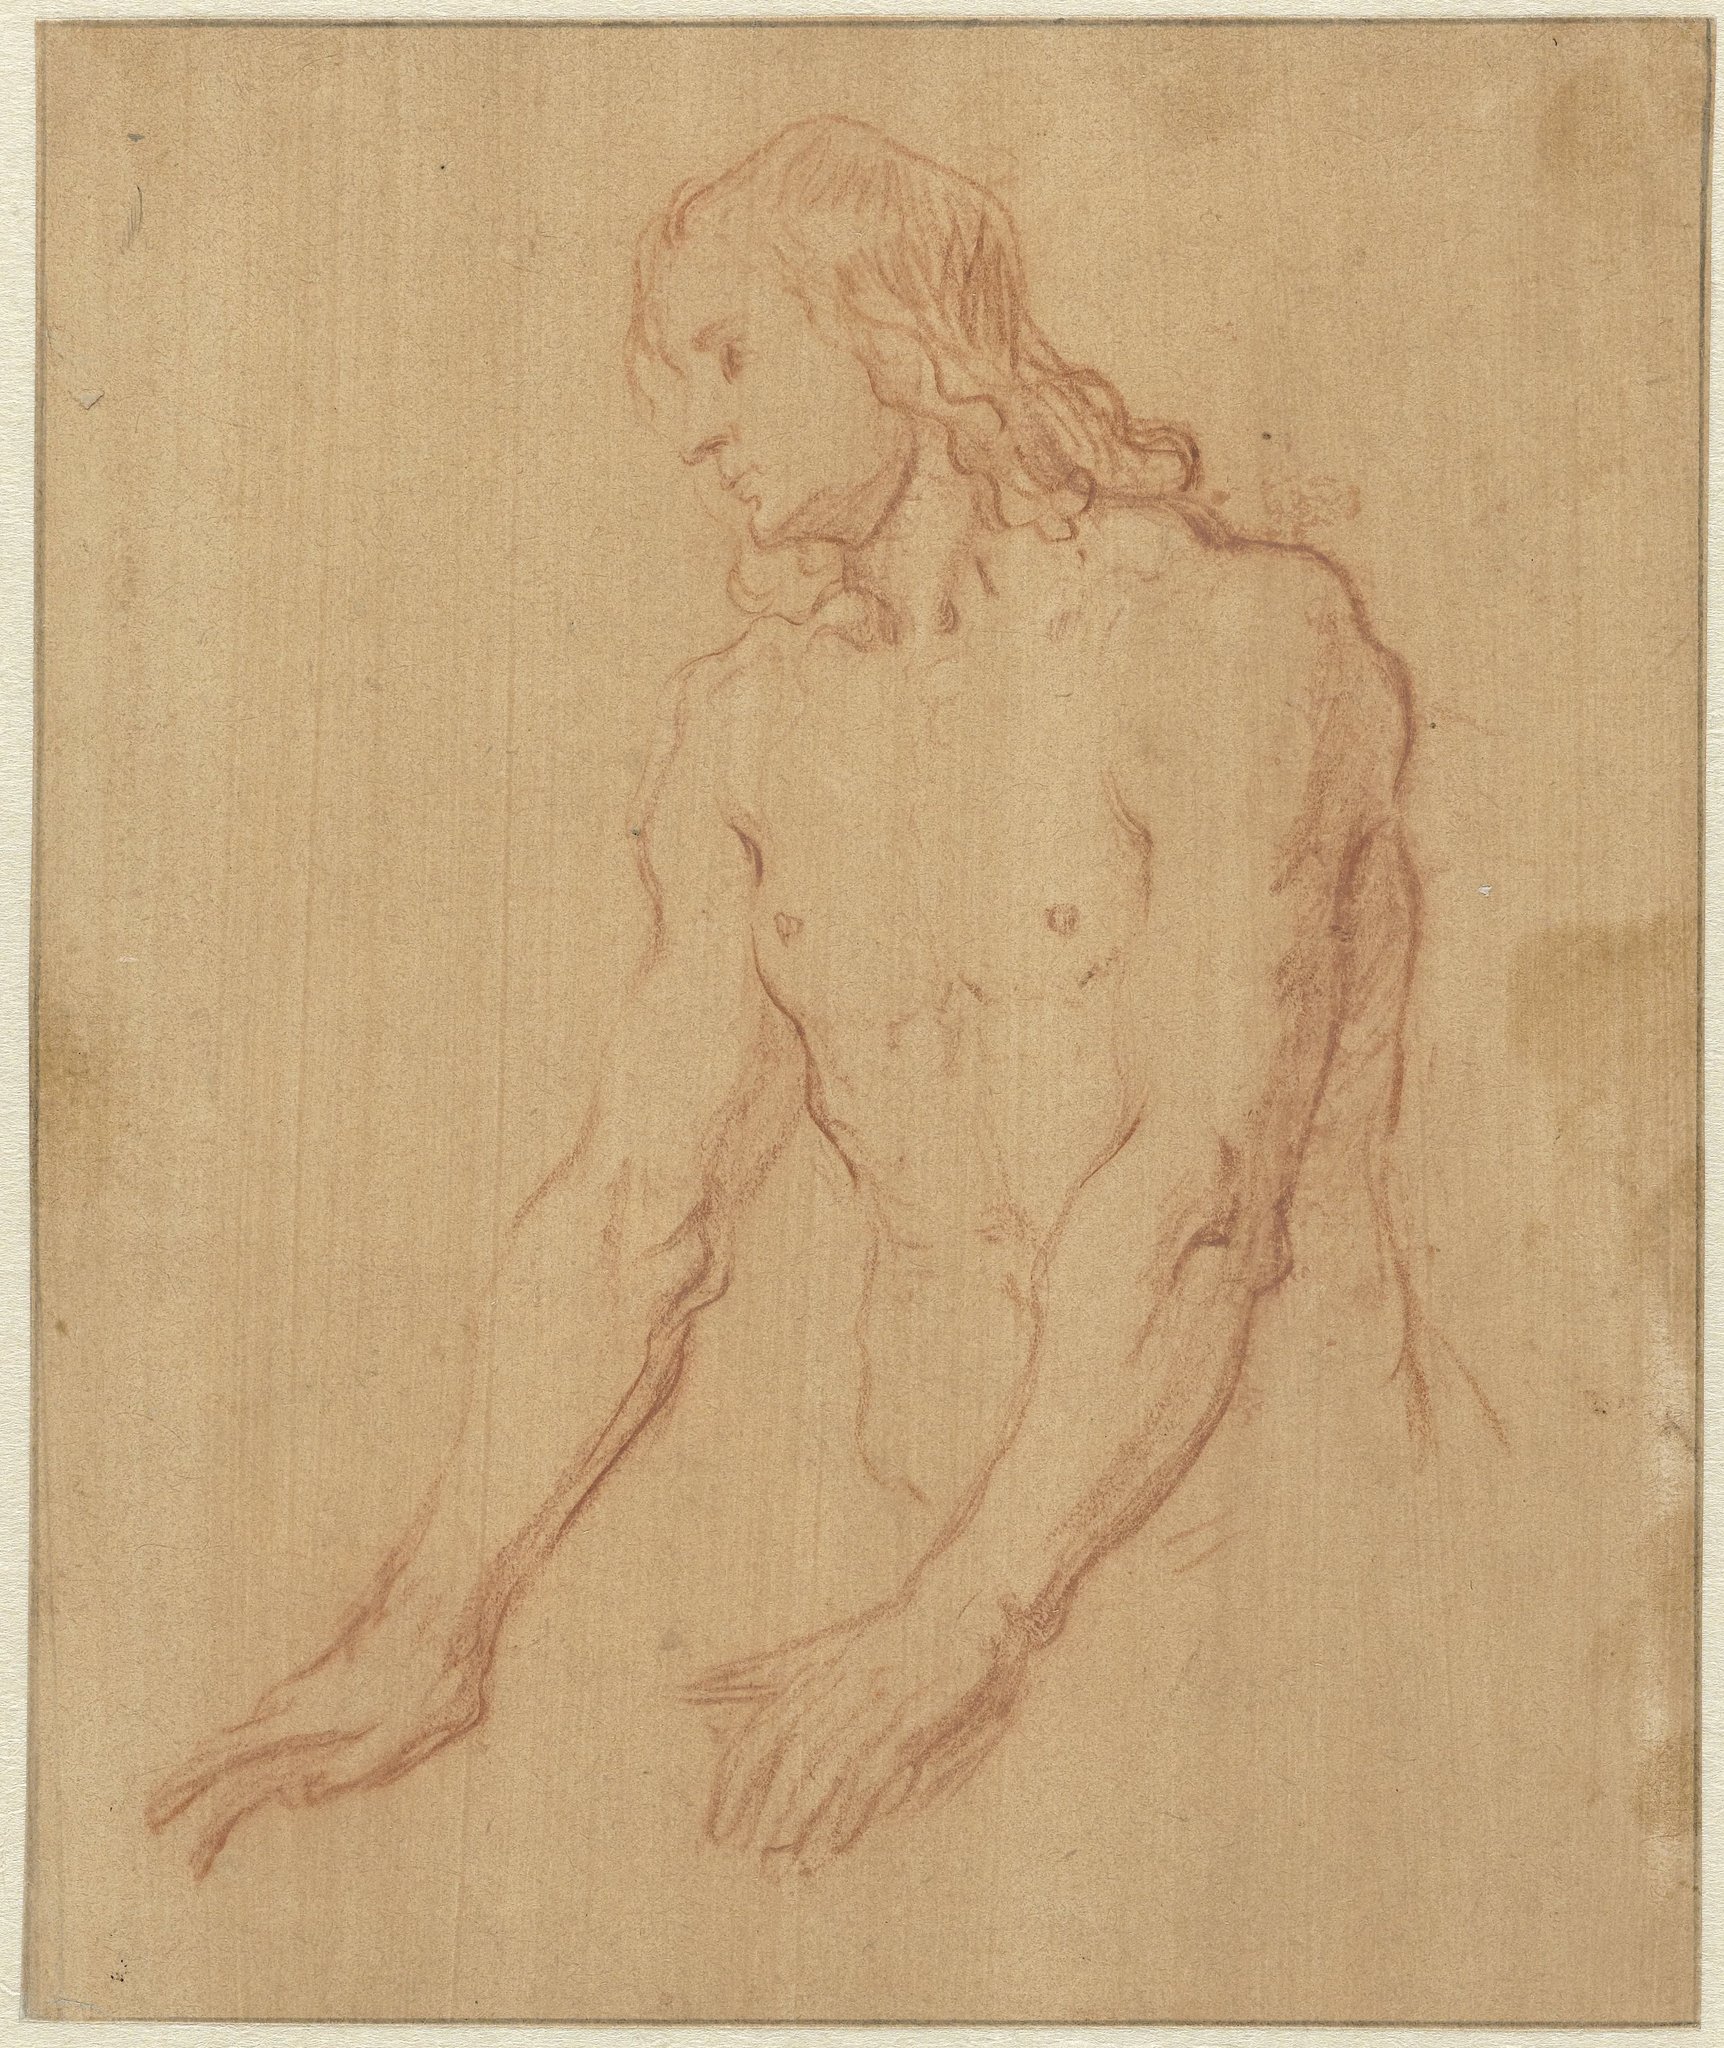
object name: drawing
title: Nude Young Man, Half Length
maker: pieter lastman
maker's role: draughtsman, painter, print maker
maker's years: 1583-1633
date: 1620-1630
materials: chalk, paper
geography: amsterdam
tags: arm stretched sidewards - aa - both arms or hands, head turned to the left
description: Rembrandt trained with Lastman around 1624. In that period, as preparation for his history pieces, Lastman drew figure studies in red chalk on paper that he had coloured yellow. This technique appealed to Rembrandt. During and shortly after his apprenticeship, Rembrandt made multiple drawings in red chalk on prepared paper. Years later he even owned a ‘boeckie vol schetsen […] met rood krijt’ (little book full of sketches […] in red chalk) by Lastman.